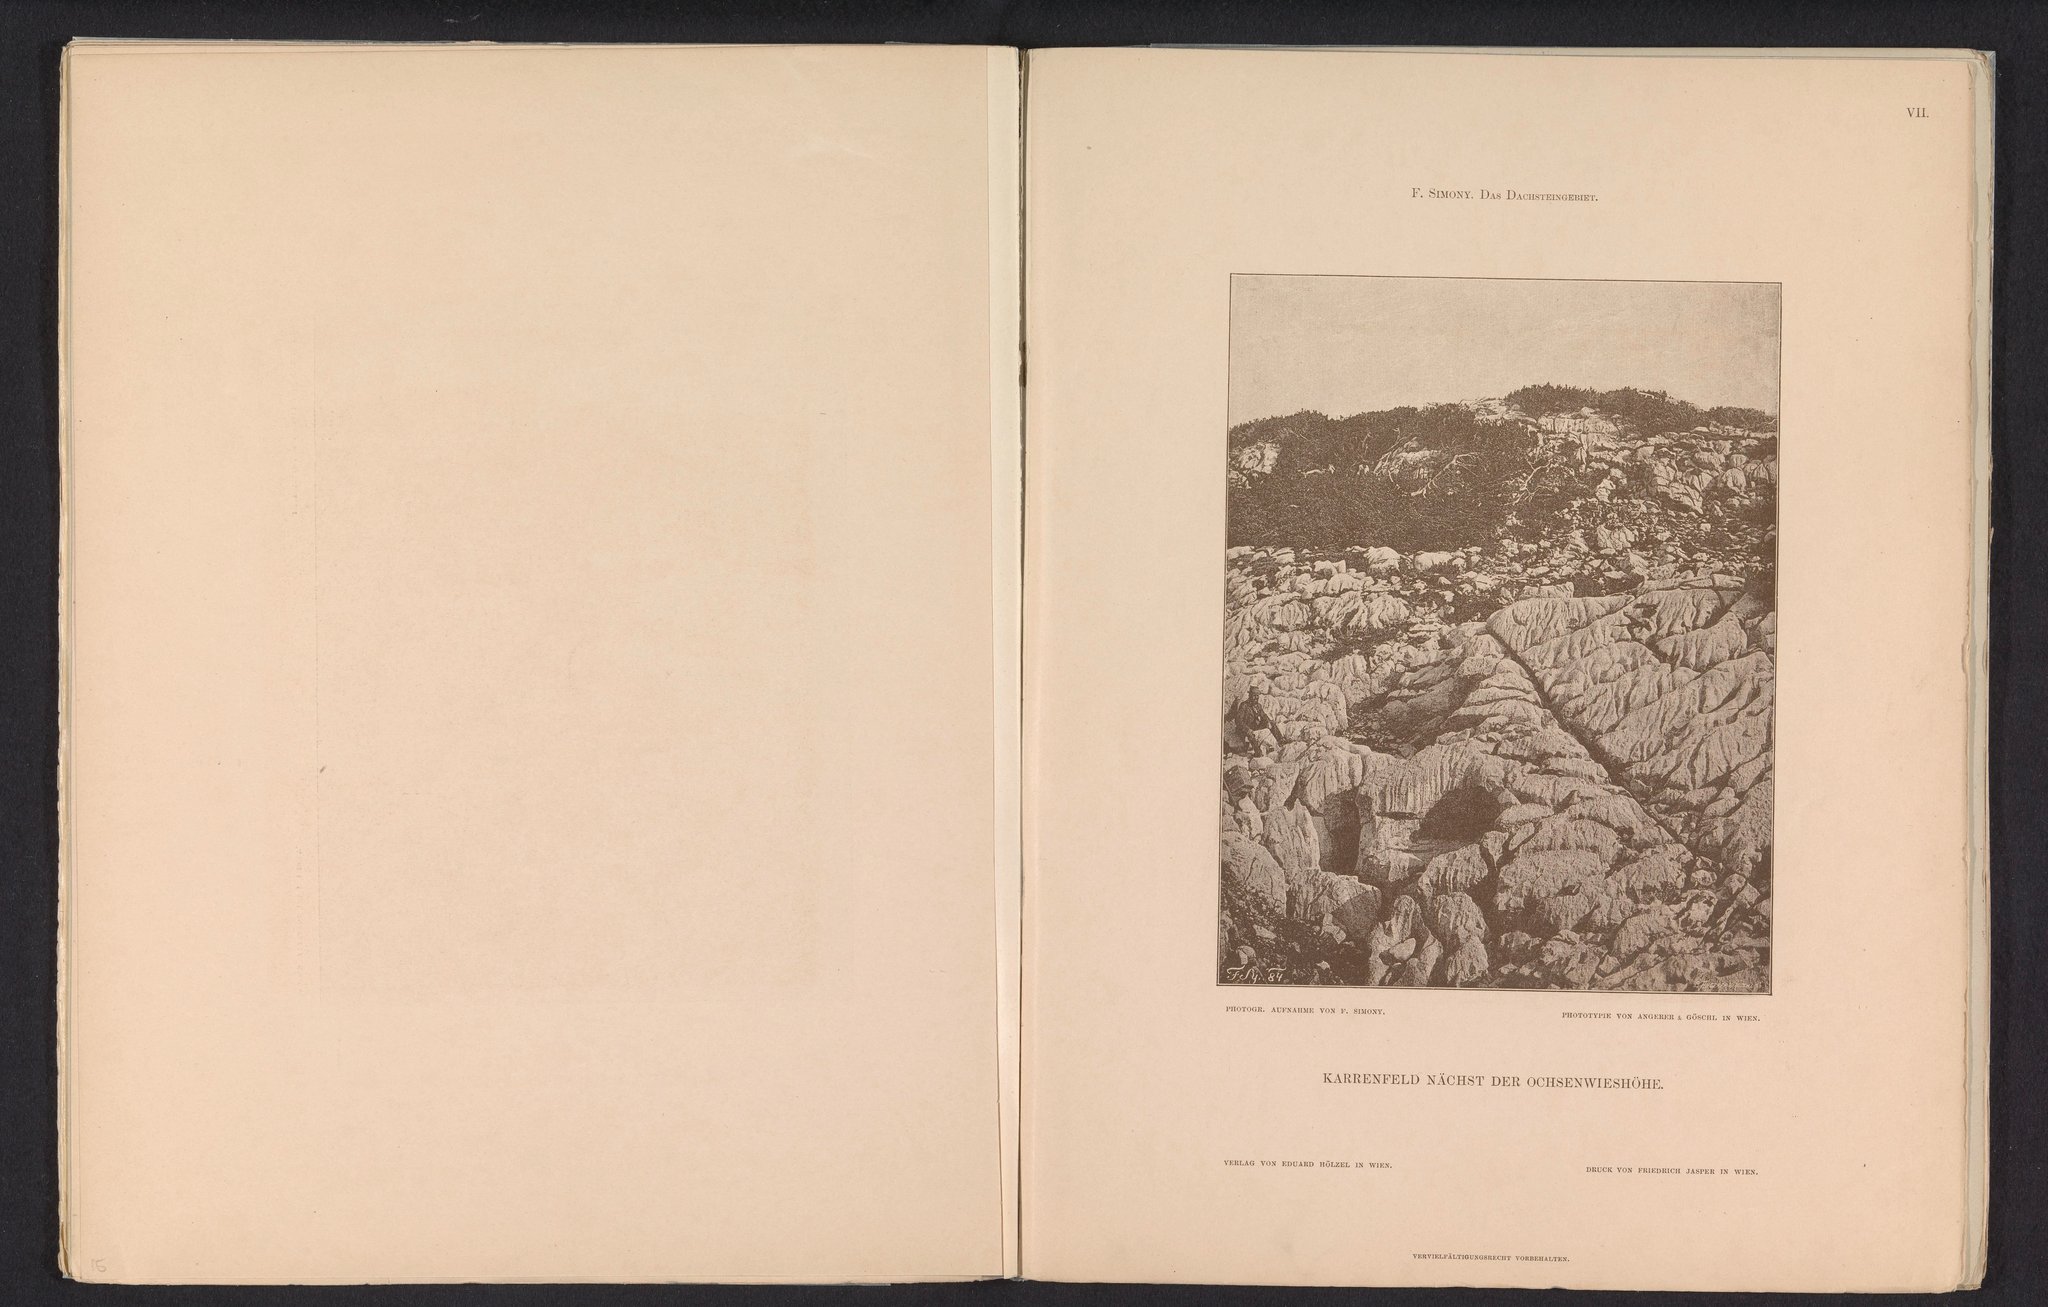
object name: photomechanical print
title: Lapiaz bij de Ochsenwieshöhe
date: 1876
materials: paper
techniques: autotype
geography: vienna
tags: rock-formations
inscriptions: number: ‘VII.’